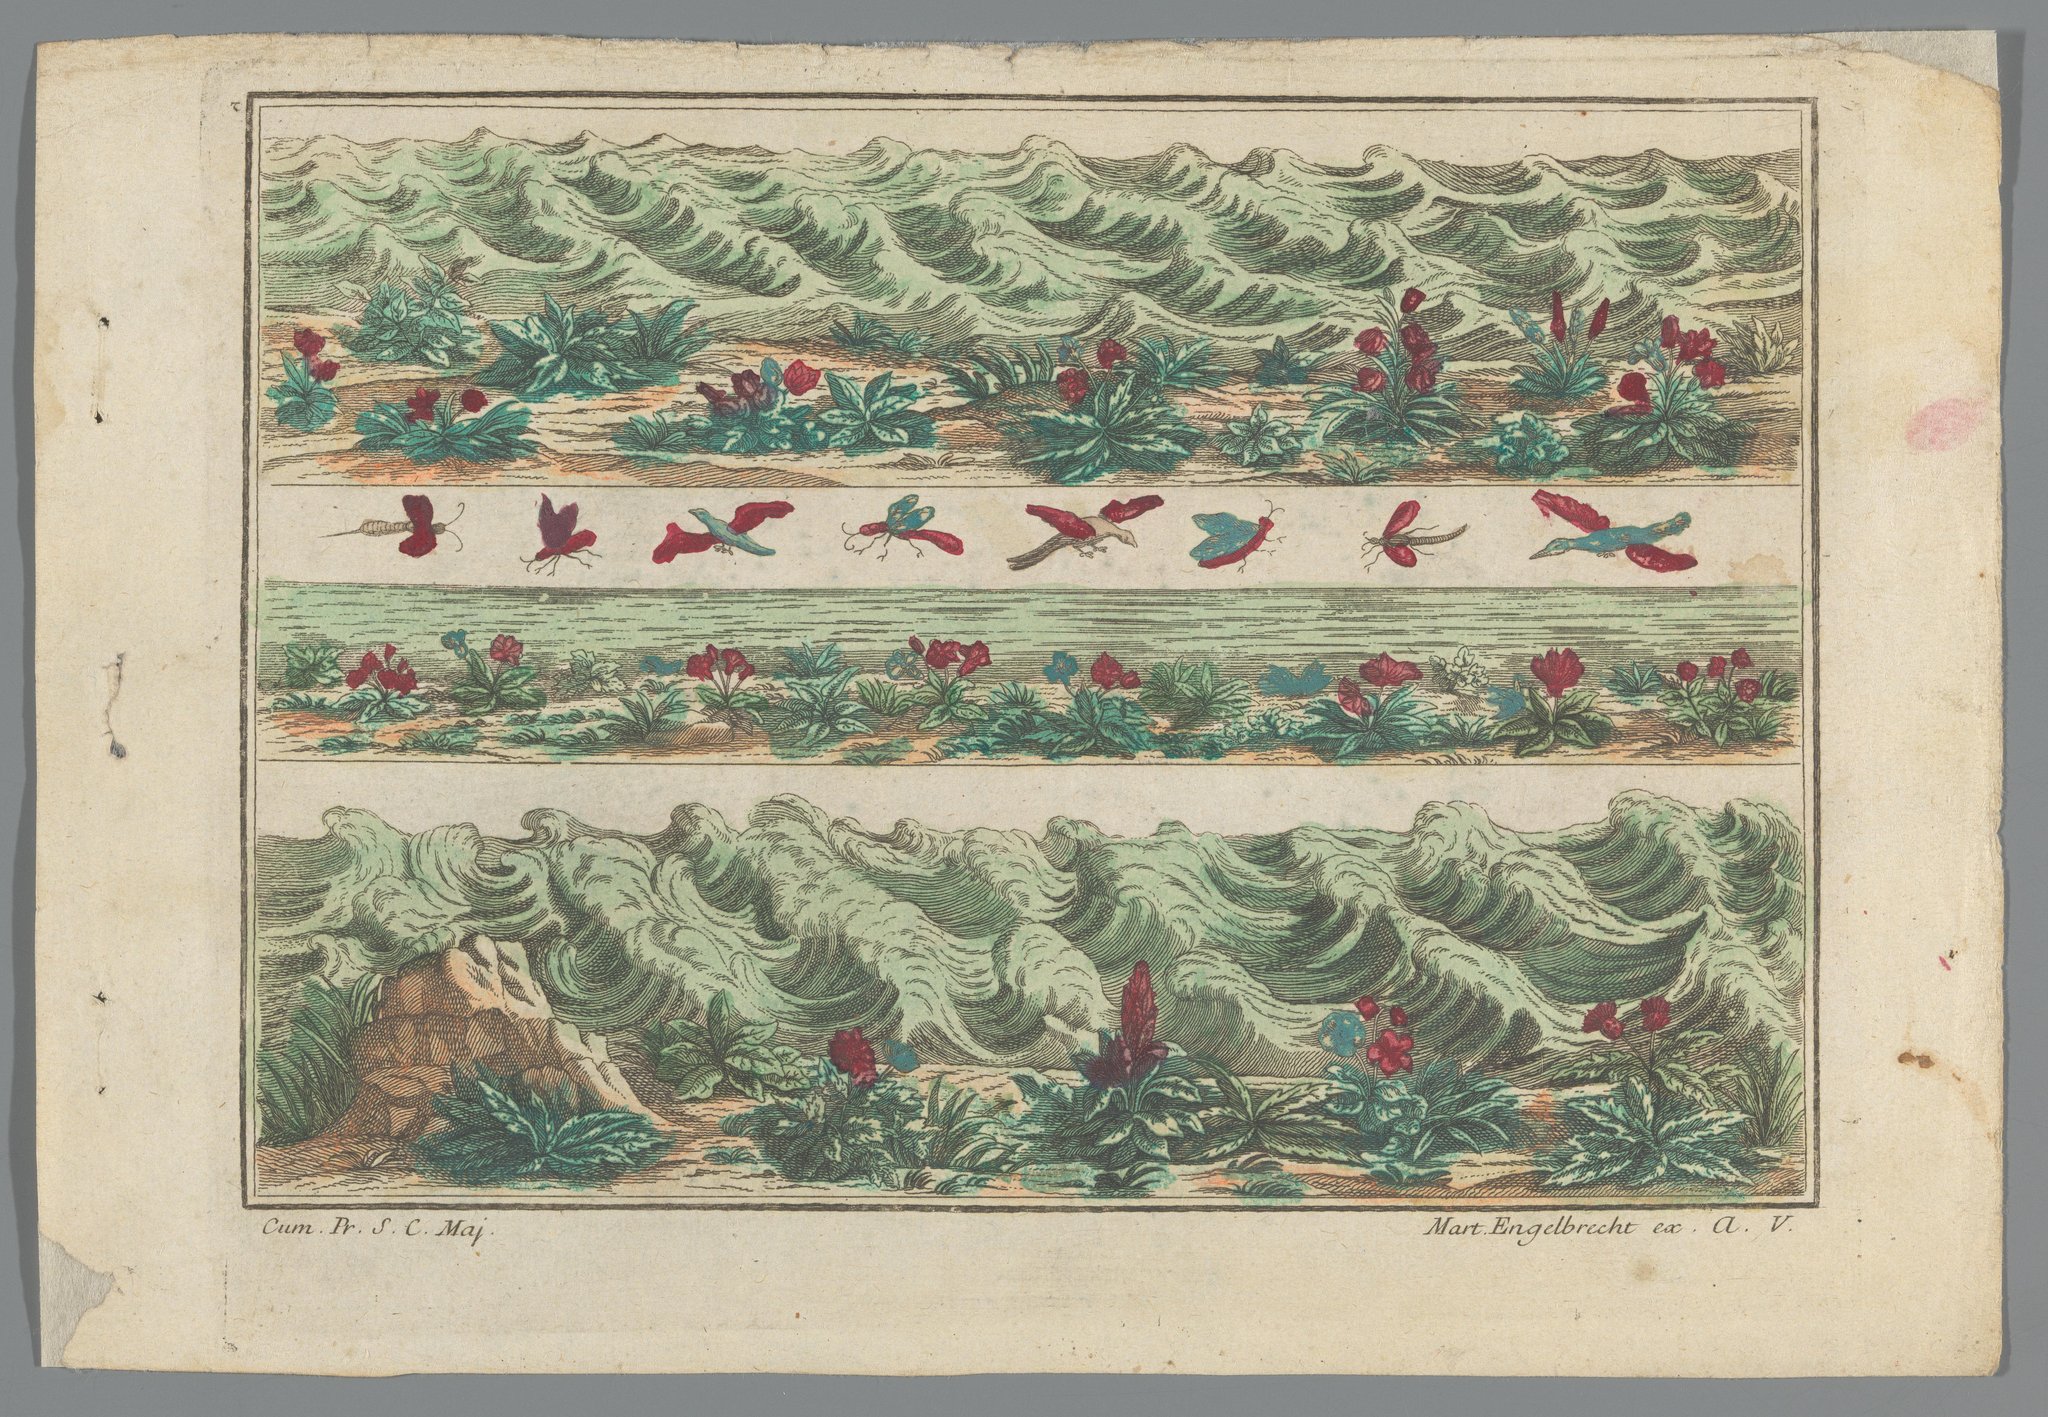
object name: print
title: Bladen met knipplaatjes en decoratieve randen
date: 1750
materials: paper, watercolor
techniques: etching, hand coloring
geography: augsburg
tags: wave, birds, insects, ornament derived from plant forms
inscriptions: collector's mark: Lugt 2228, collector's mark: Lugt 2760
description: Drie landschappen met water en een strook land, met vogels, insekten en bloemen. Een van 39 bladen met knipplaatjes en decoratieve randen.